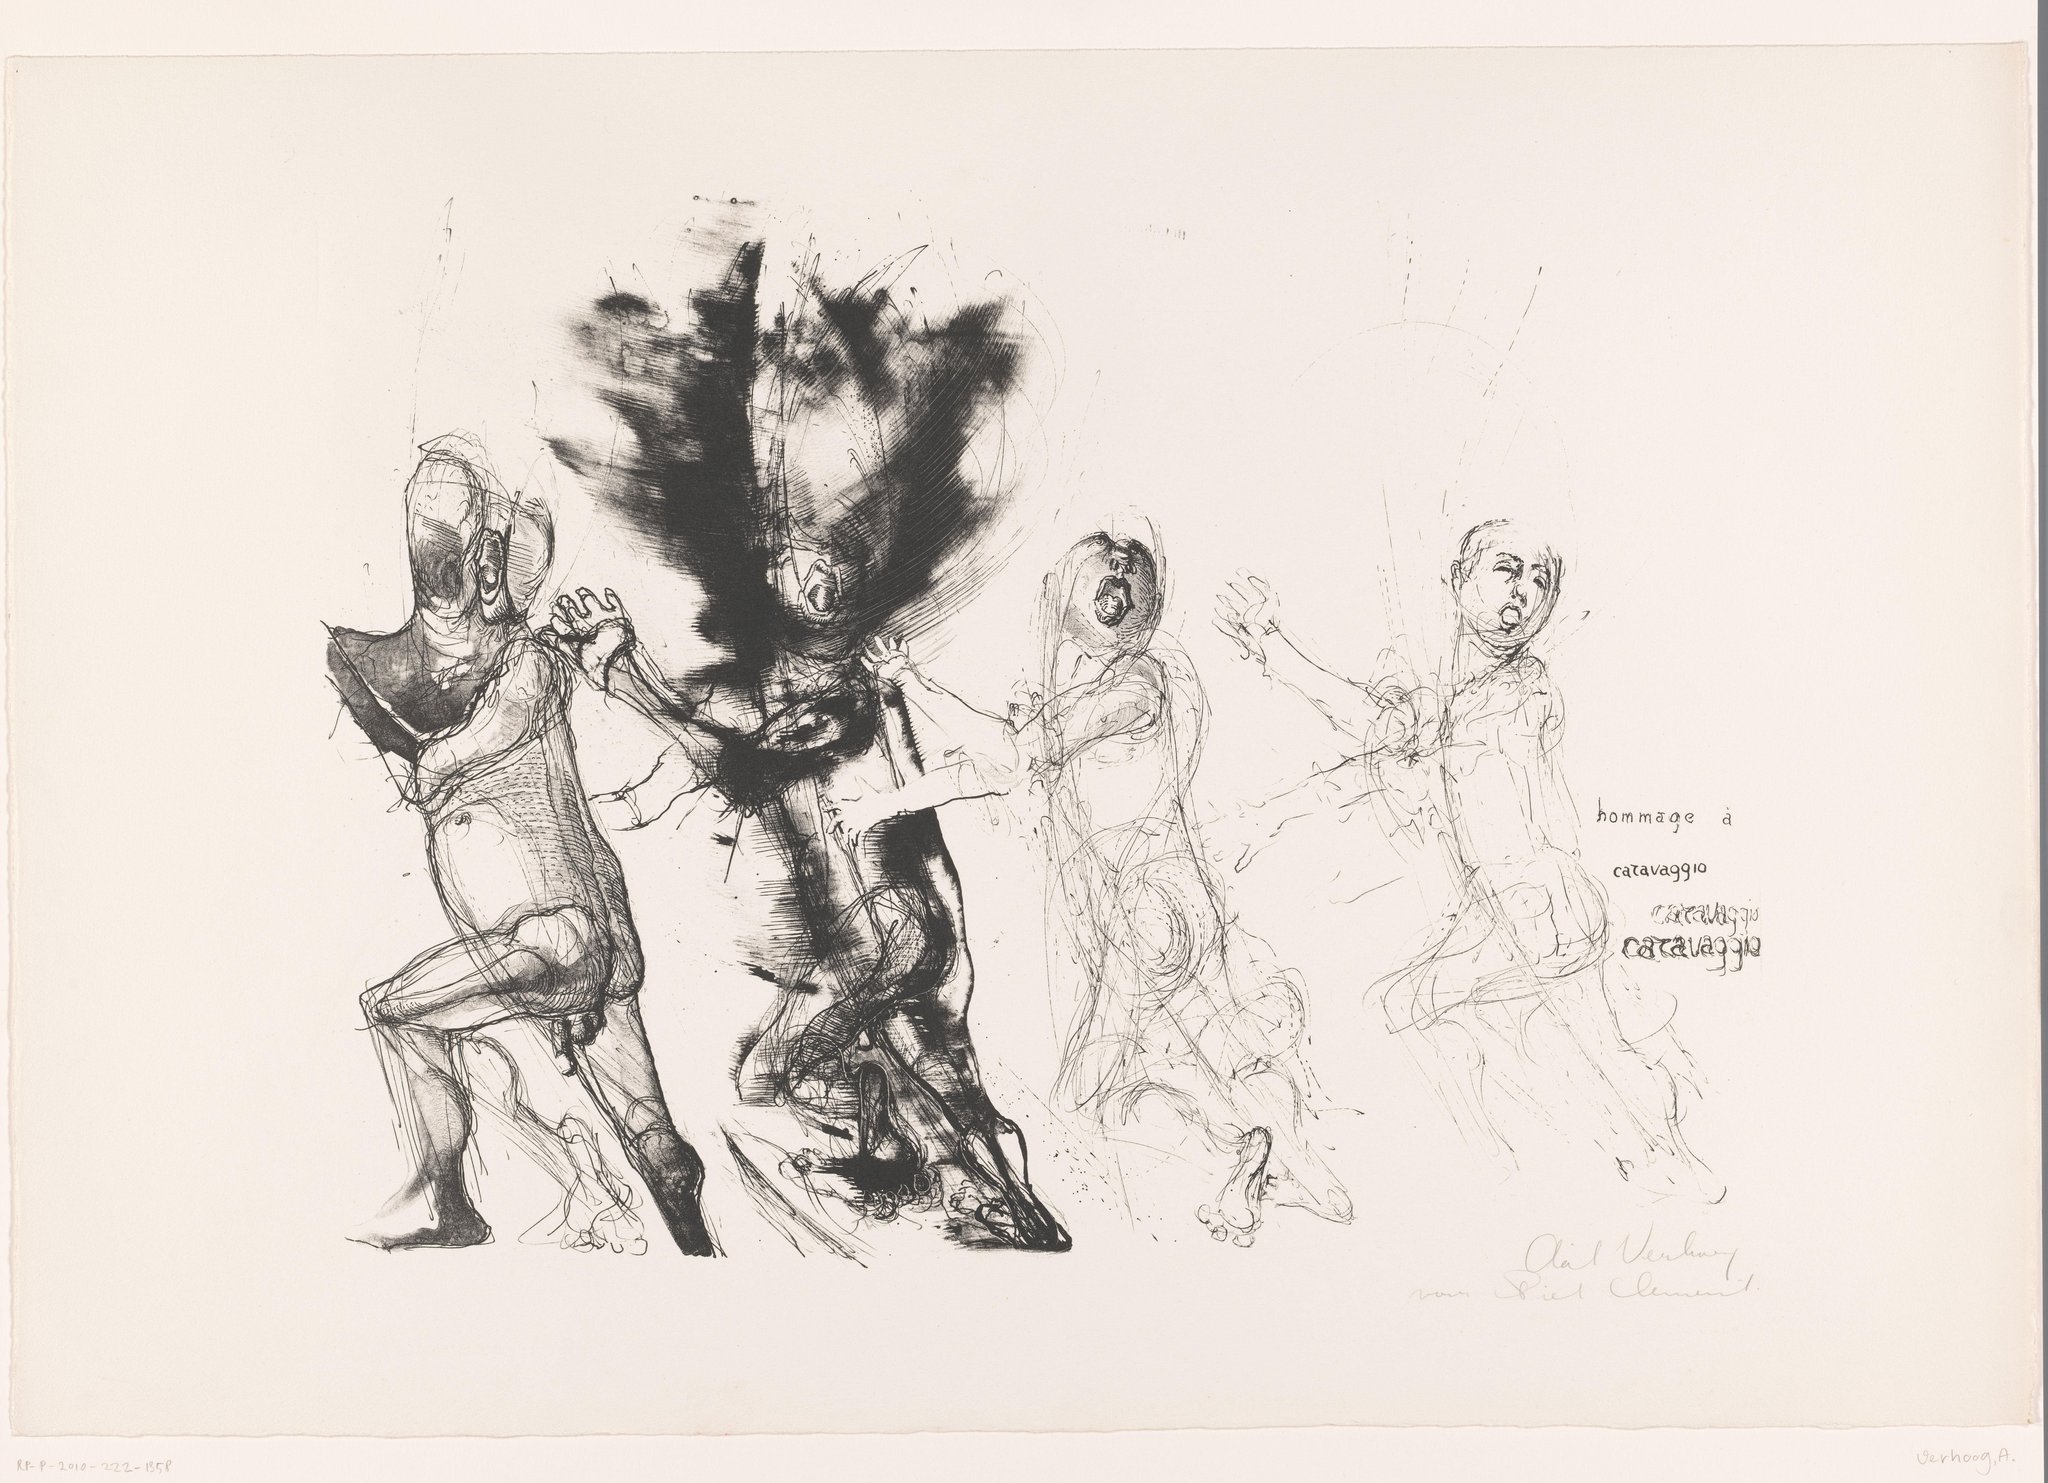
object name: print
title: Hommage à Caravaggio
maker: aat verhoog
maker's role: print maker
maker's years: 1933-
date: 1965-1980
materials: paper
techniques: lithograph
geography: amsterdam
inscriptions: title: ‘hommage à / caravaggio/ caravaggio/ caravaggio’, signature: ‘Aat Verhoog’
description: Vier maal dezelfde schreeuwende naakte figuur, verschillend weergegeven.